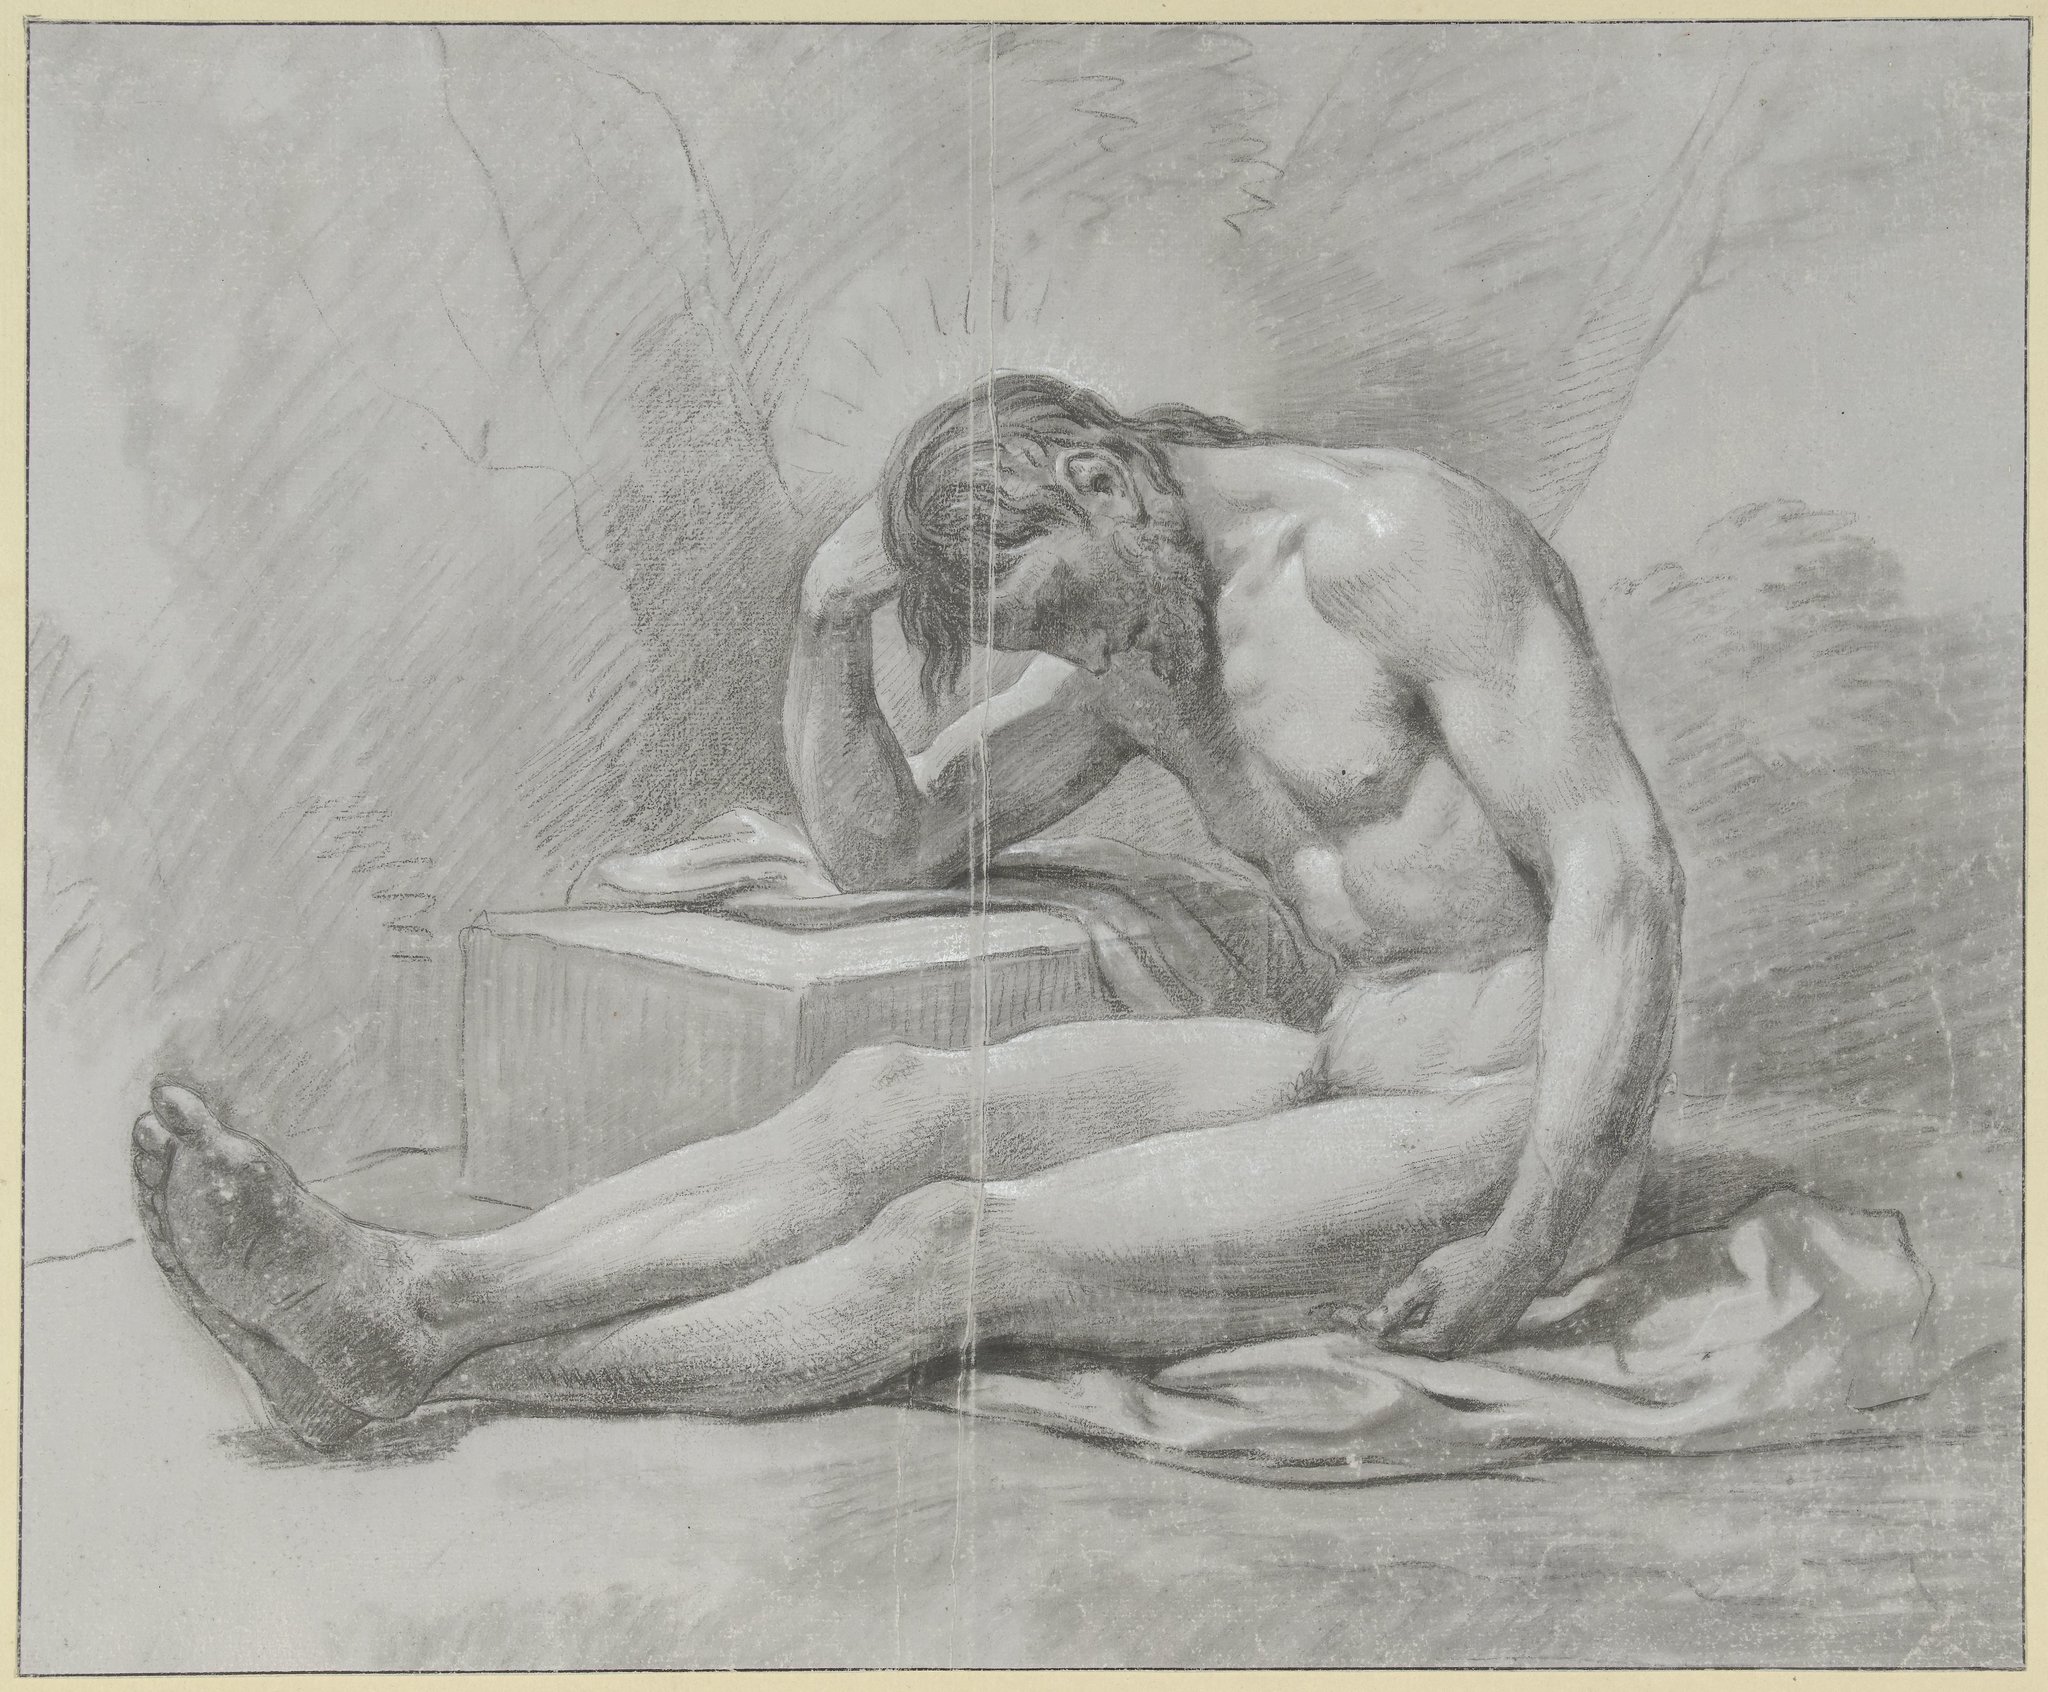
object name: drawing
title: Zittend mannelijk naakt, op de grond, met de rechterarm leunend op een blok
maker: jean grandjean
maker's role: draughtsman, print maker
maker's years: 1752-1781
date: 1765-1781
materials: chalk, paper